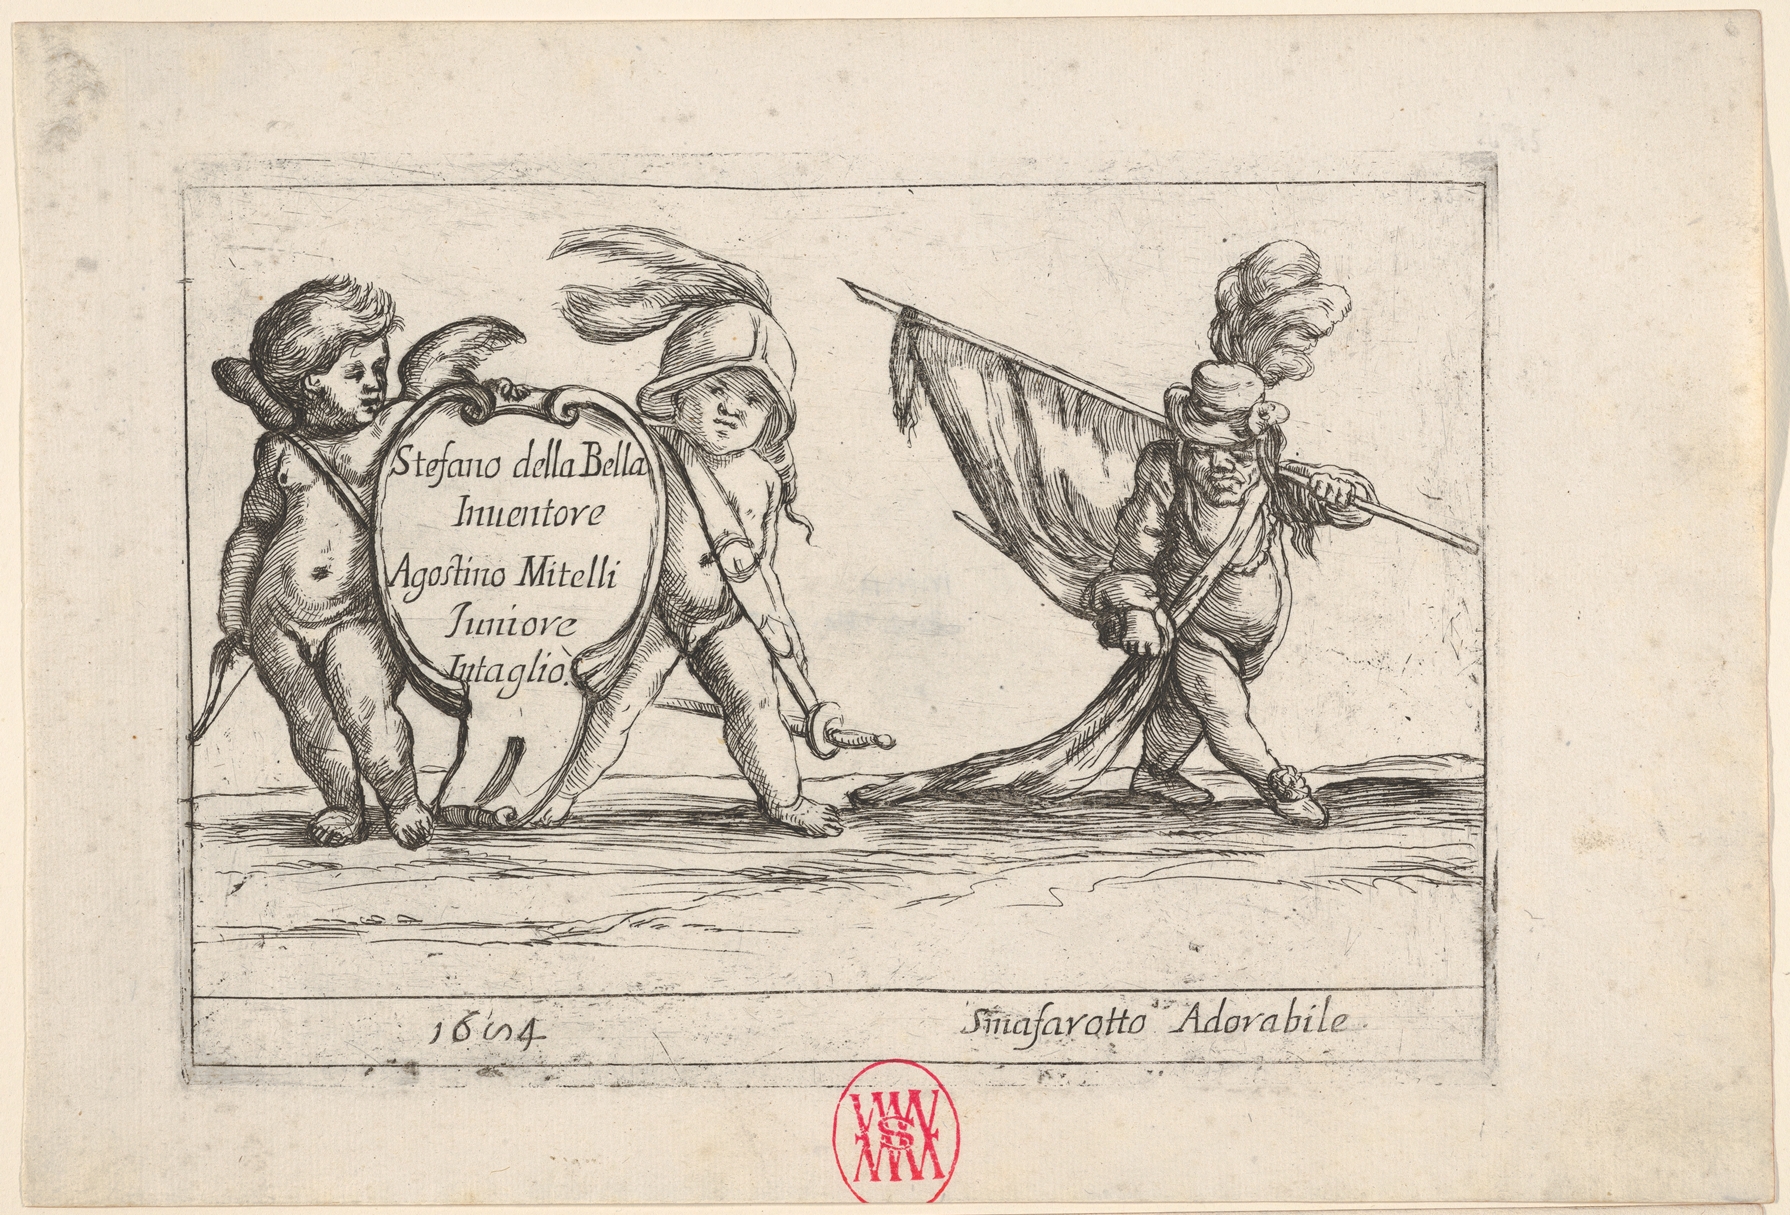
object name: print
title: Callot figures; two children carrying a cartouche to left, a dwarf in a plumed hat carrying a standard at right, from "Six grotesques" (Six pièces de figures grotesques)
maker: agostino mitelli ii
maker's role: artist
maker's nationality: italian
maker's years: 1671-1696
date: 1684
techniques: etching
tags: cartouches,children